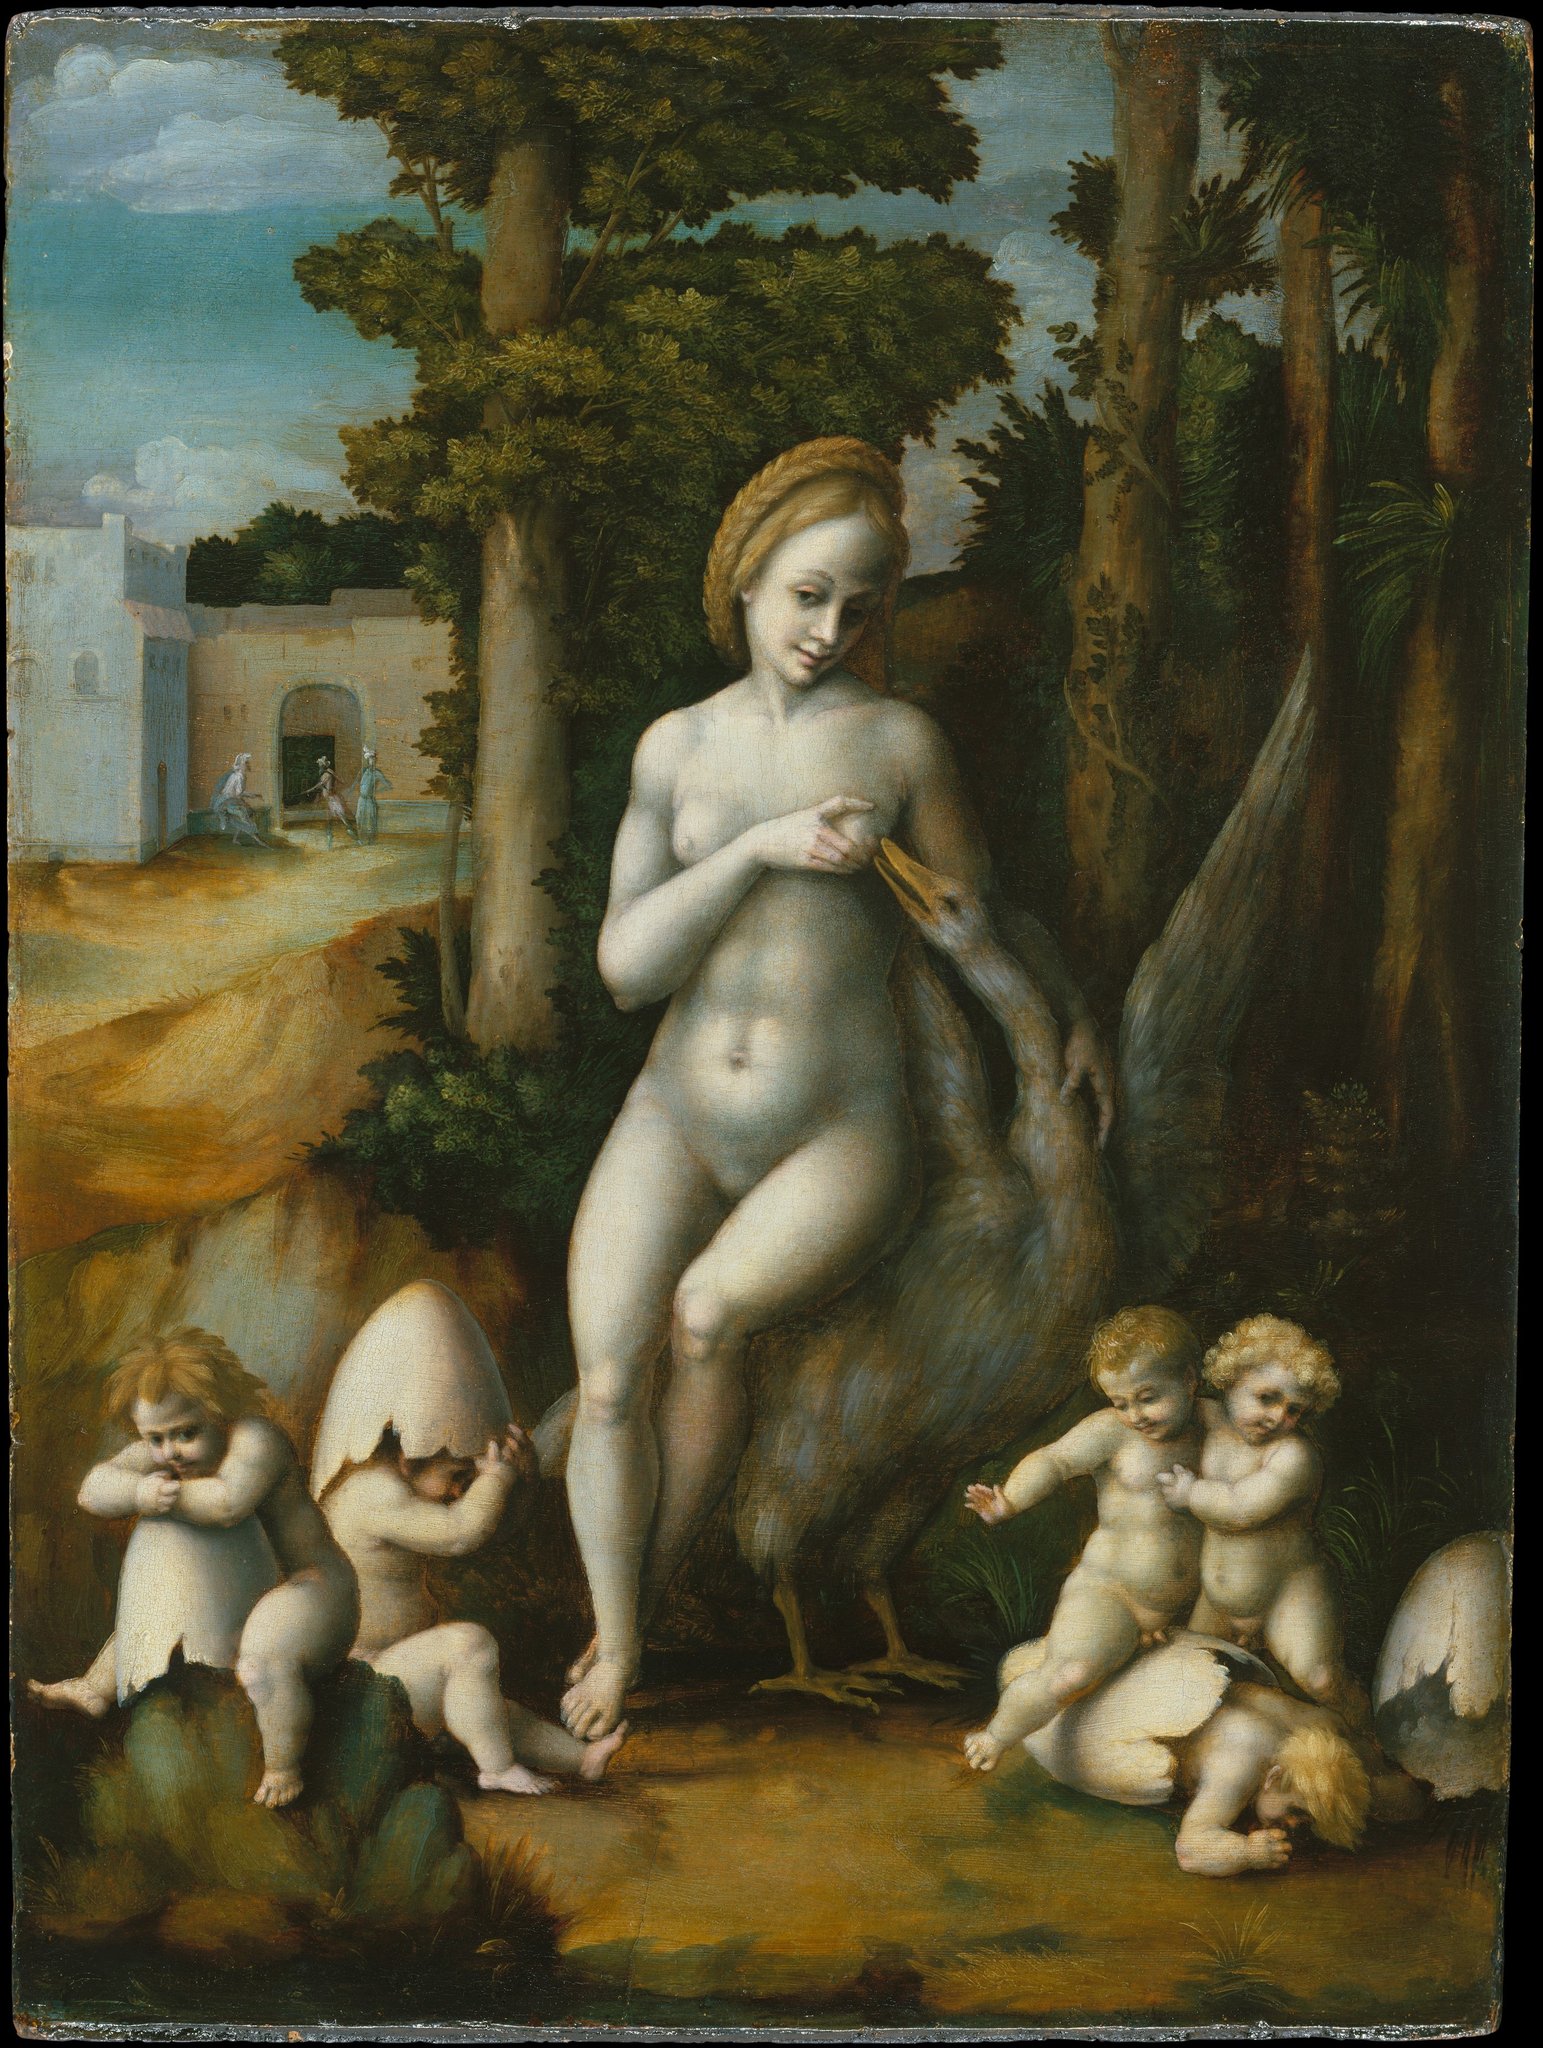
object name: painting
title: Leda and the Swan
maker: bachiacca (francesco d'ubertino verdi)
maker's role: artist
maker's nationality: italian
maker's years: 1494-1557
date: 1515-1557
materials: oil, wood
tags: infants,female nudes,leda,swans,eggs